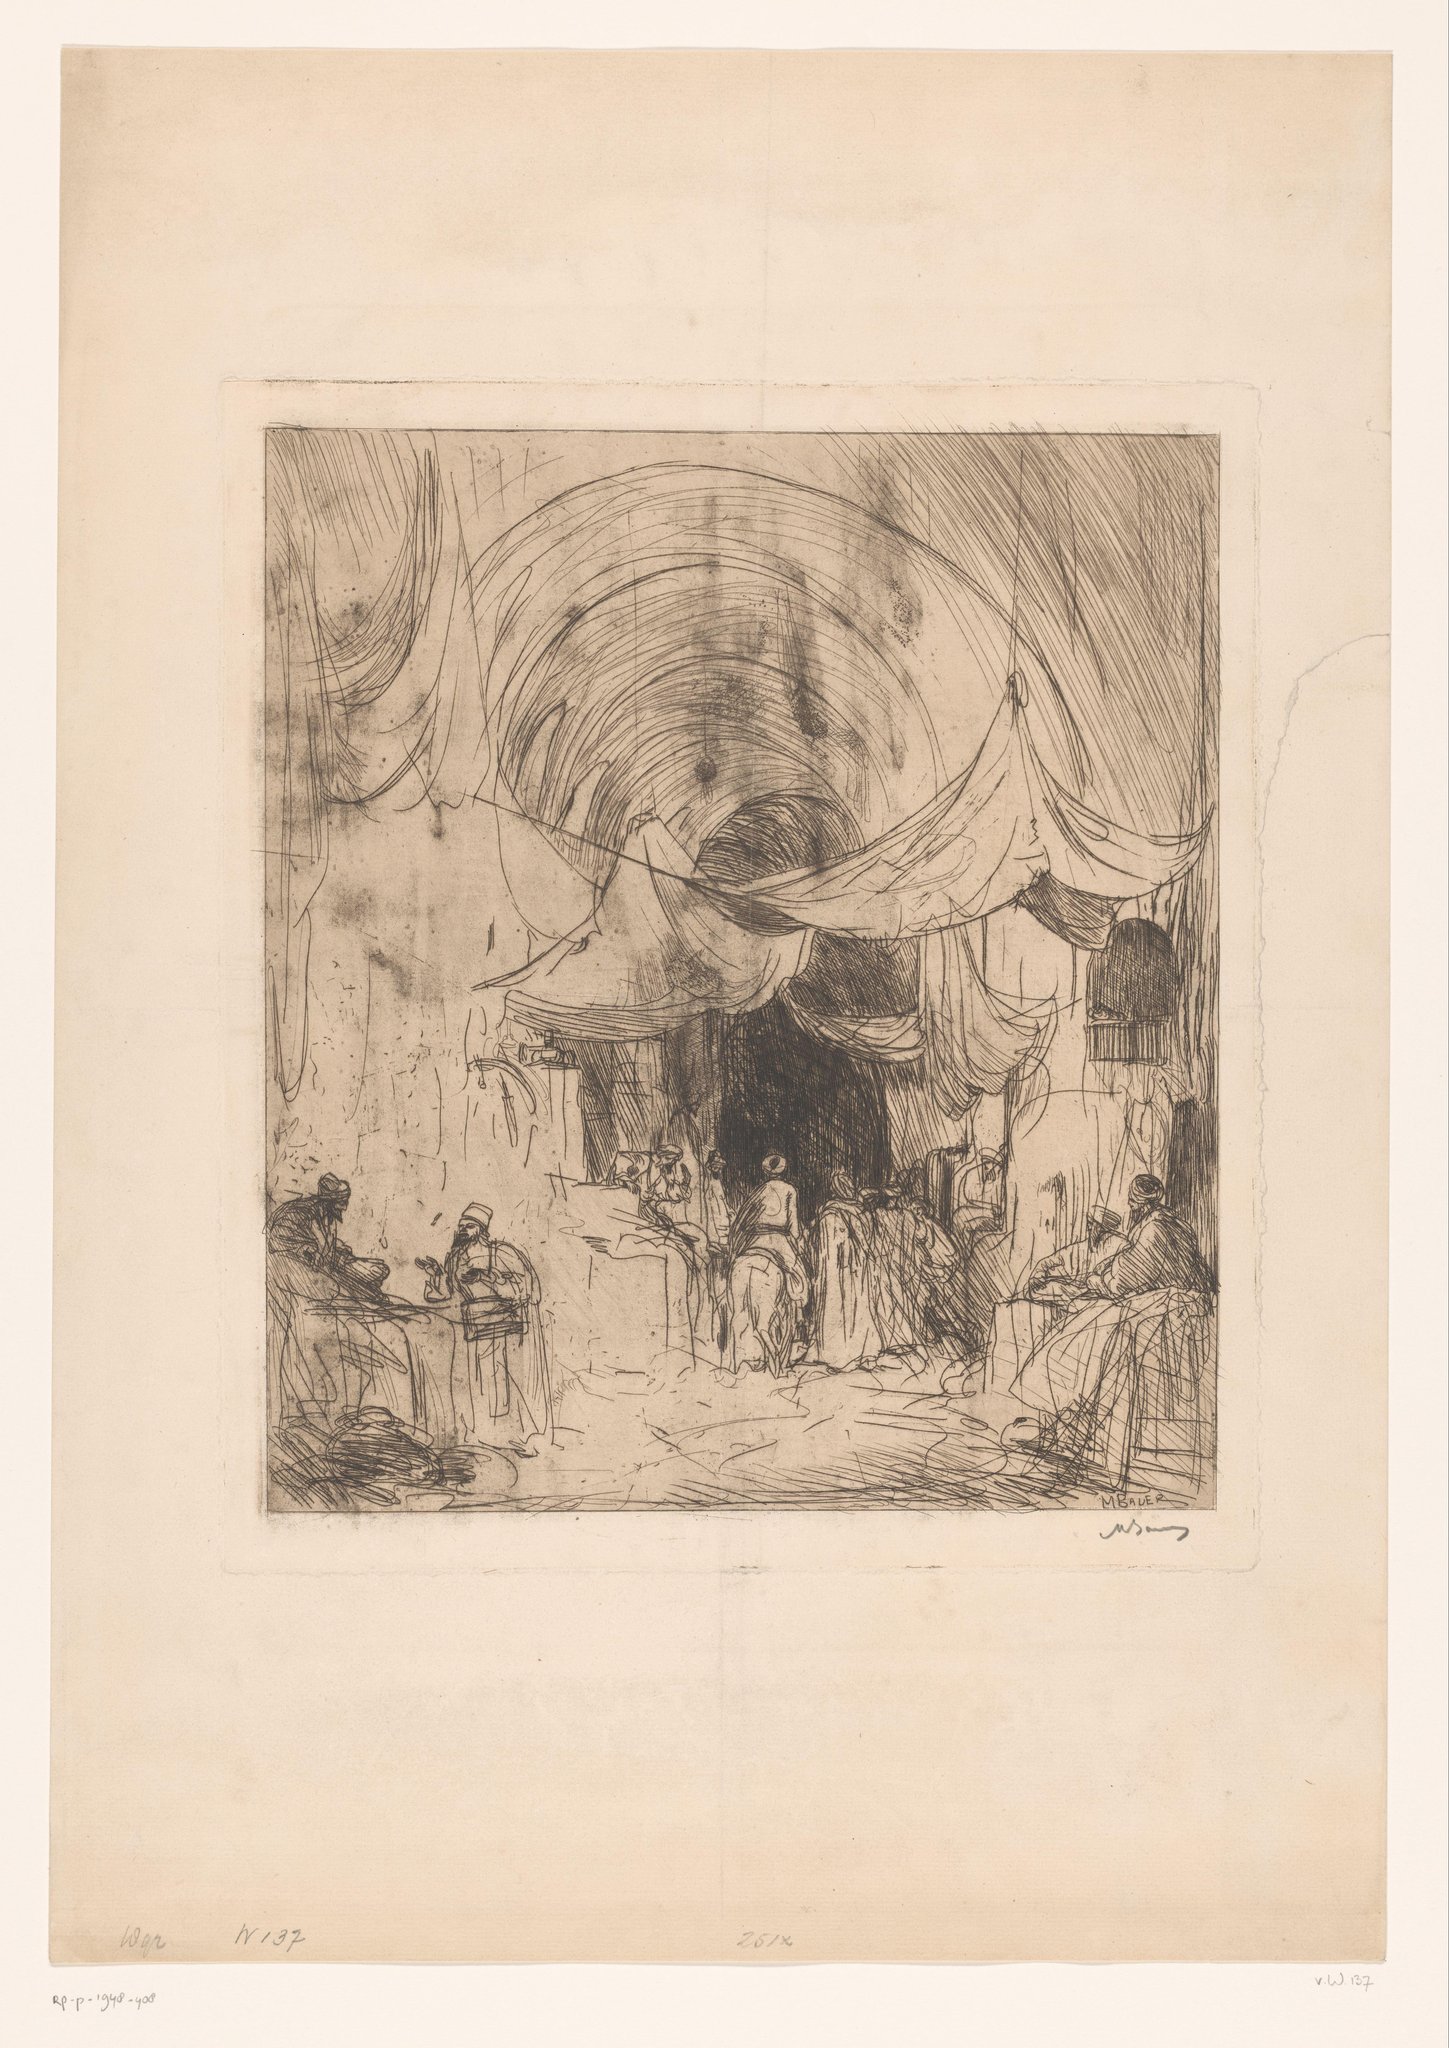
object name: print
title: Turkse bazaar met gespannen zeilen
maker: marius bauer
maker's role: draughtsman, print maker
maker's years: 1867-1932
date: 1892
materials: paper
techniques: etching, intaglio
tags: head-gear, persons engaged in trade and commerce, market-hall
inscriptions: collector's mark: Lugt 2228